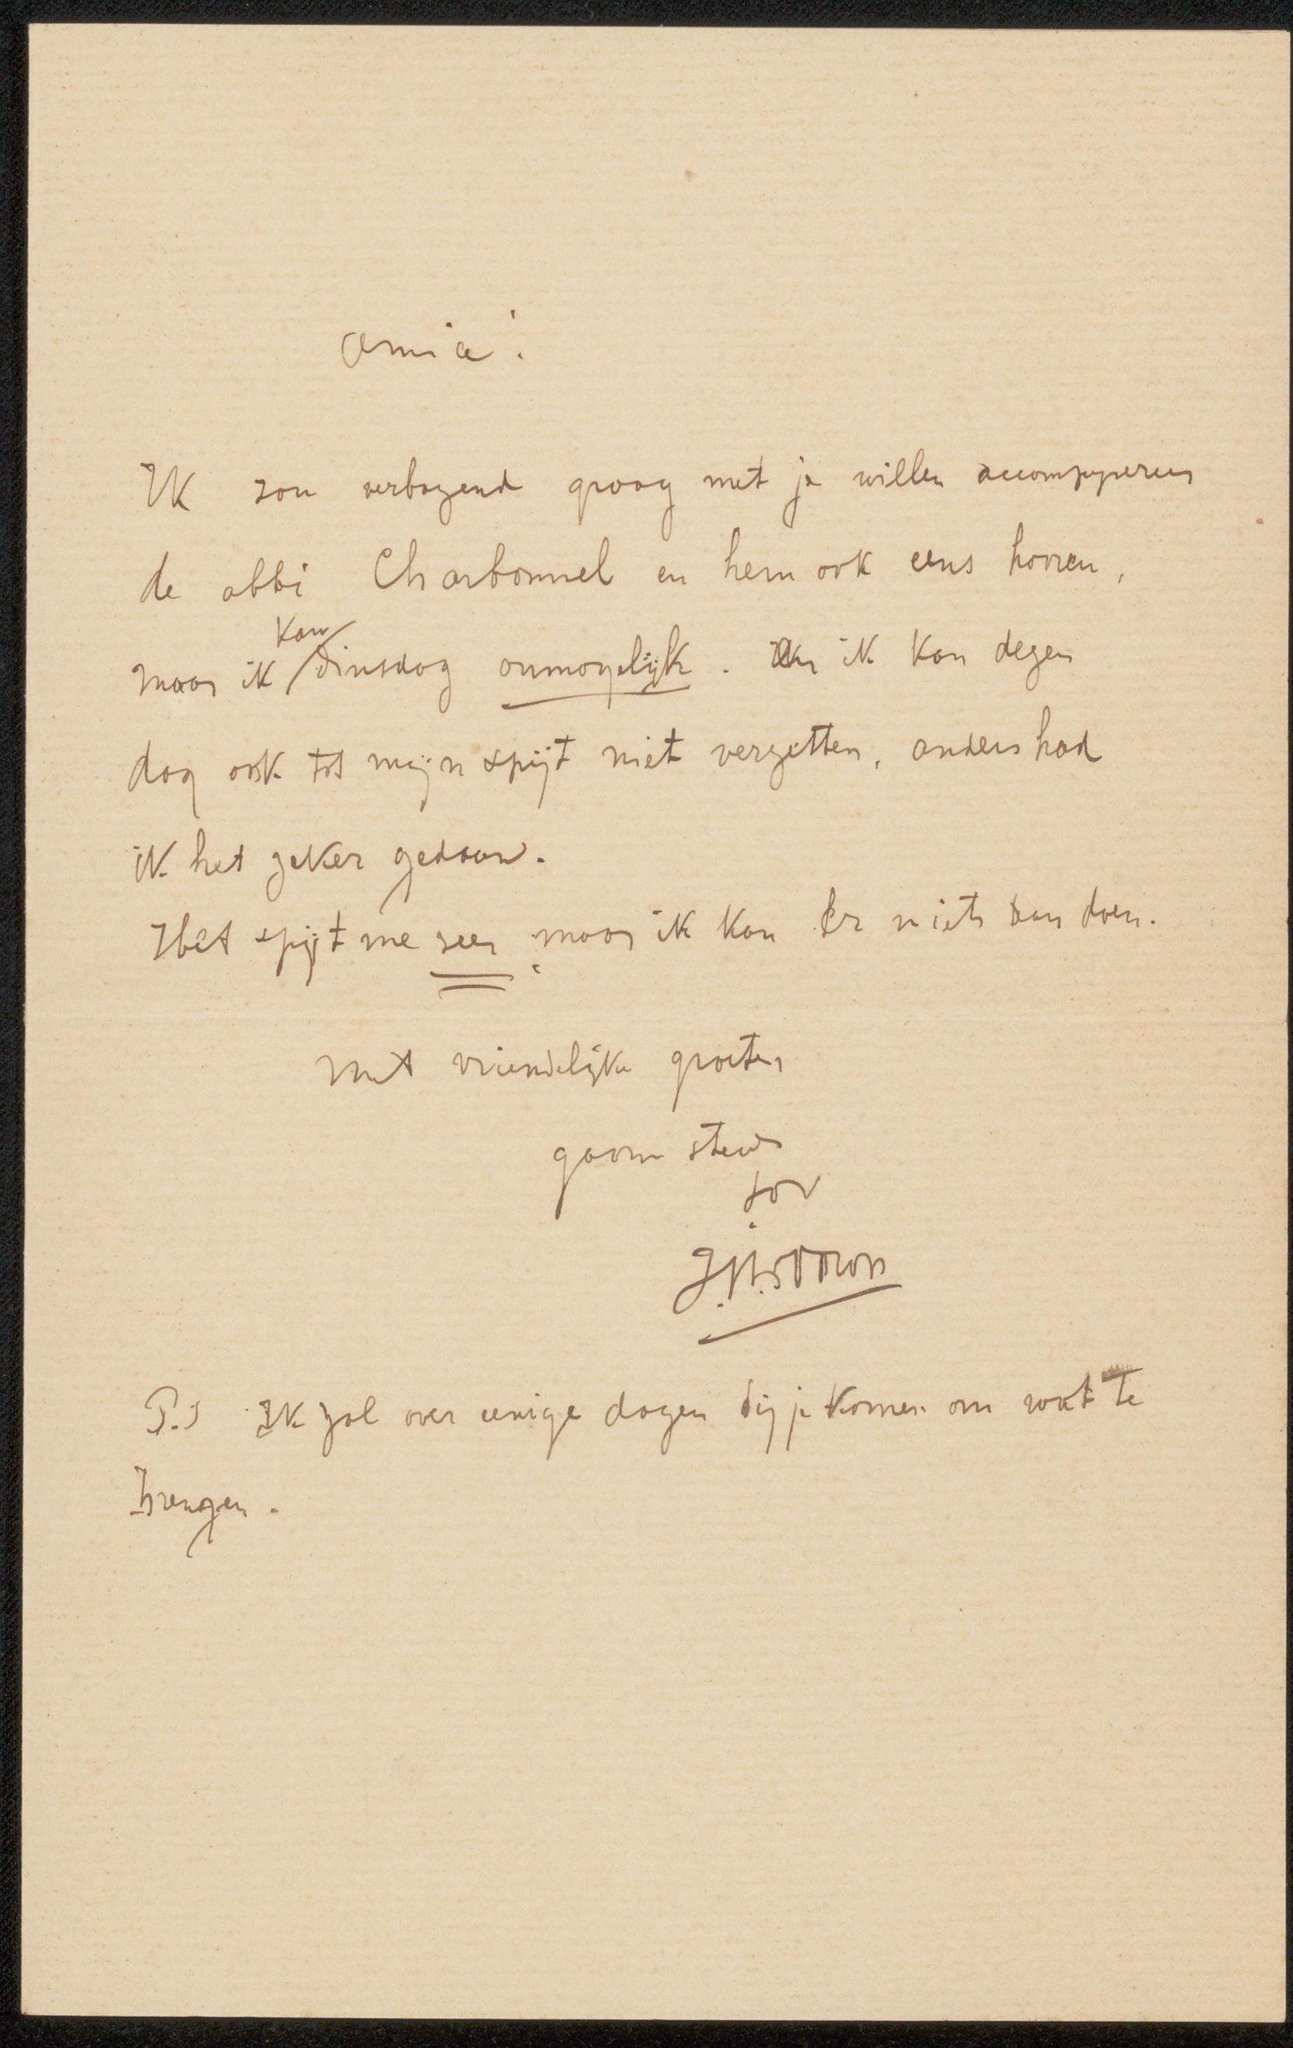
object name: letter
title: Brief aan Philip Zilcken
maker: jan toorop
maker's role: draughtsman, painter, print maker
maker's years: 1858-1928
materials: ink, paper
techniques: pen, writing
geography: the hague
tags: philip zilcken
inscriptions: collector's mark: ‘RPK’